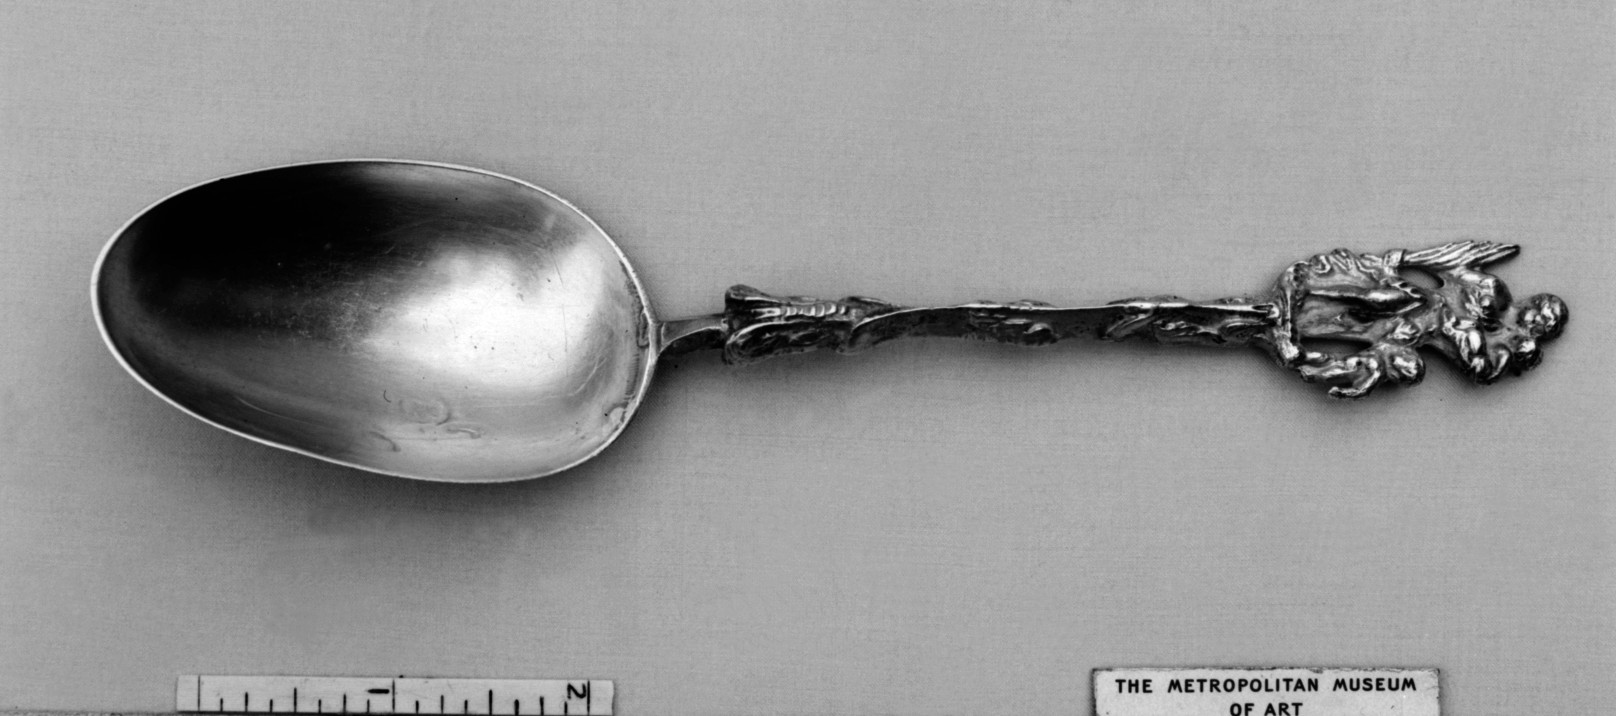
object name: spoon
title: Figure-top spoon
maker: hendrik kamerling de jonge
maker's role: maker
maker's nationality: dutch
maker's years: 1730-1776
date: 1734-1766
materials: silver